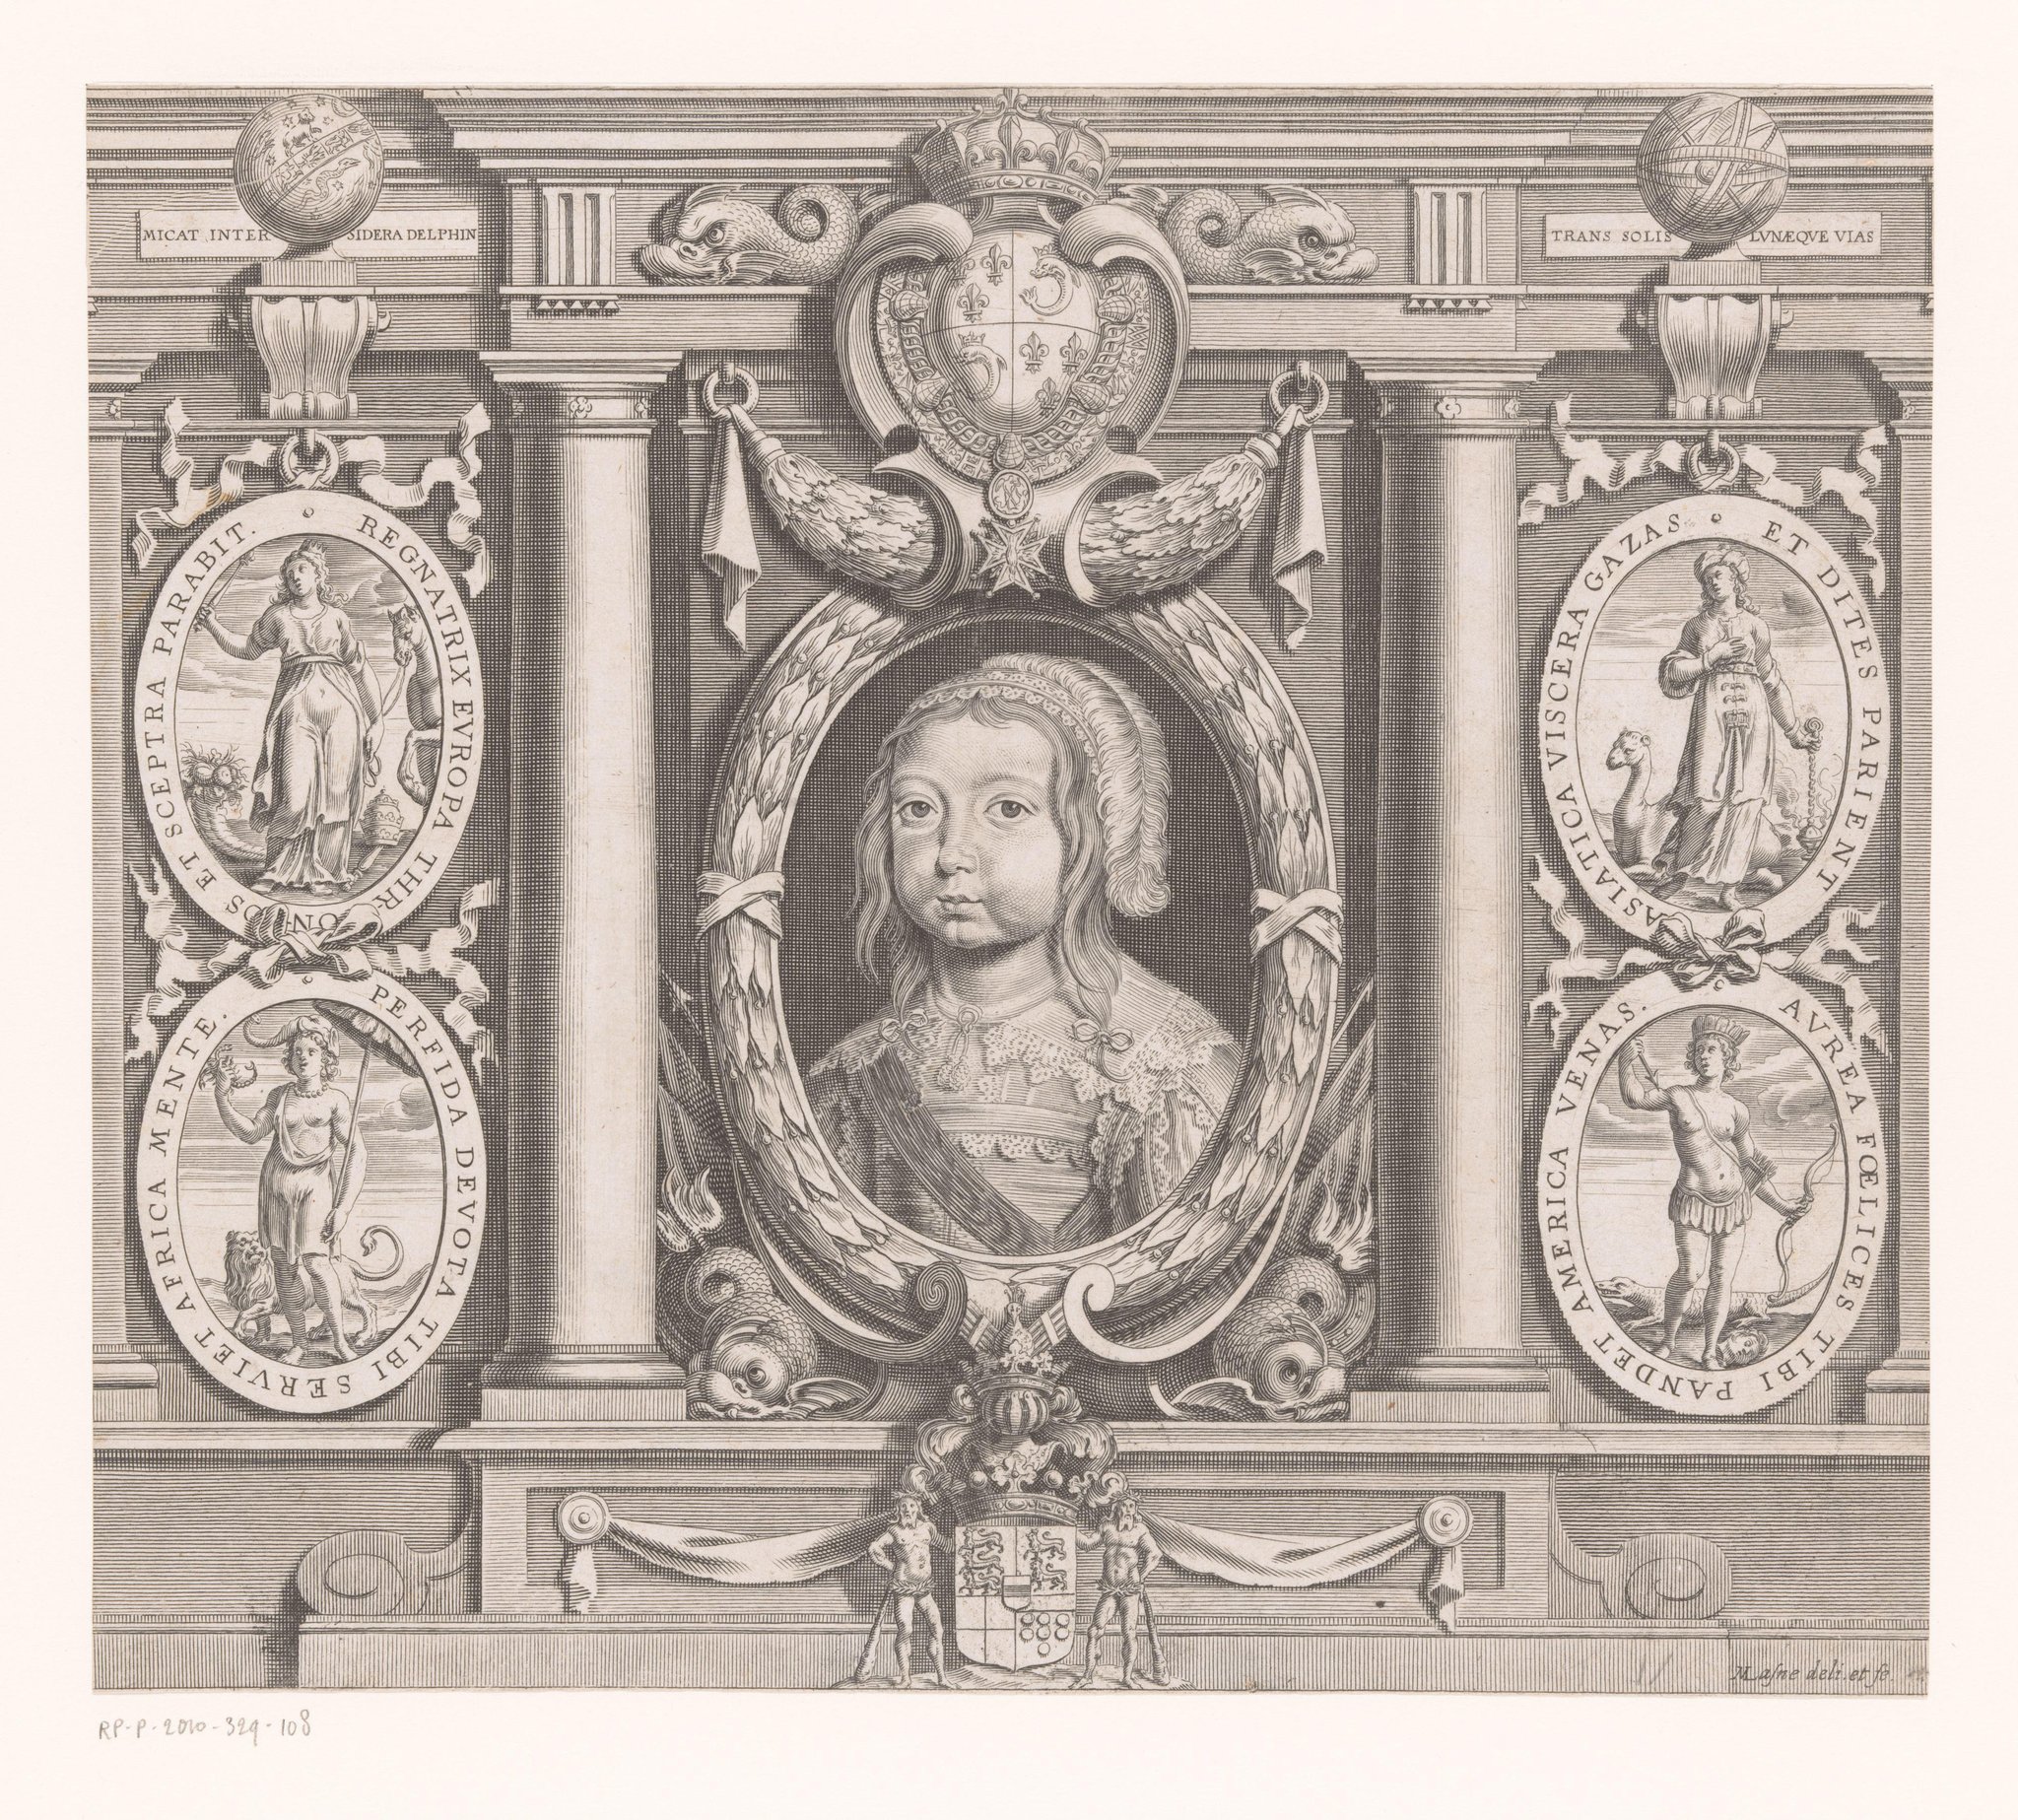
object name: print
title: Portrait of Louis XIV of France as a Child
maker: michel lasne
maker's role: print maker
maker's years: 1590-1667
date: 1600-1667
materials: paper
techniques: engraving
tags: historical persons, ornament ~ cartouche, armorial bearing, heraldry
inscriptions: collector's mark: Lugt 2228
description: Louis XIV became the king of France at the age of four. His reign lasted 72 years and 110 days, the longest in recorded history. This portrait shows him shortly before his coronation, when he was still dauphin (heir apparent to the French crown). In the ornate architectural frame, Lasne incorporated references to Louis’ future is a great ruler, such as globes and personifications of the continents.